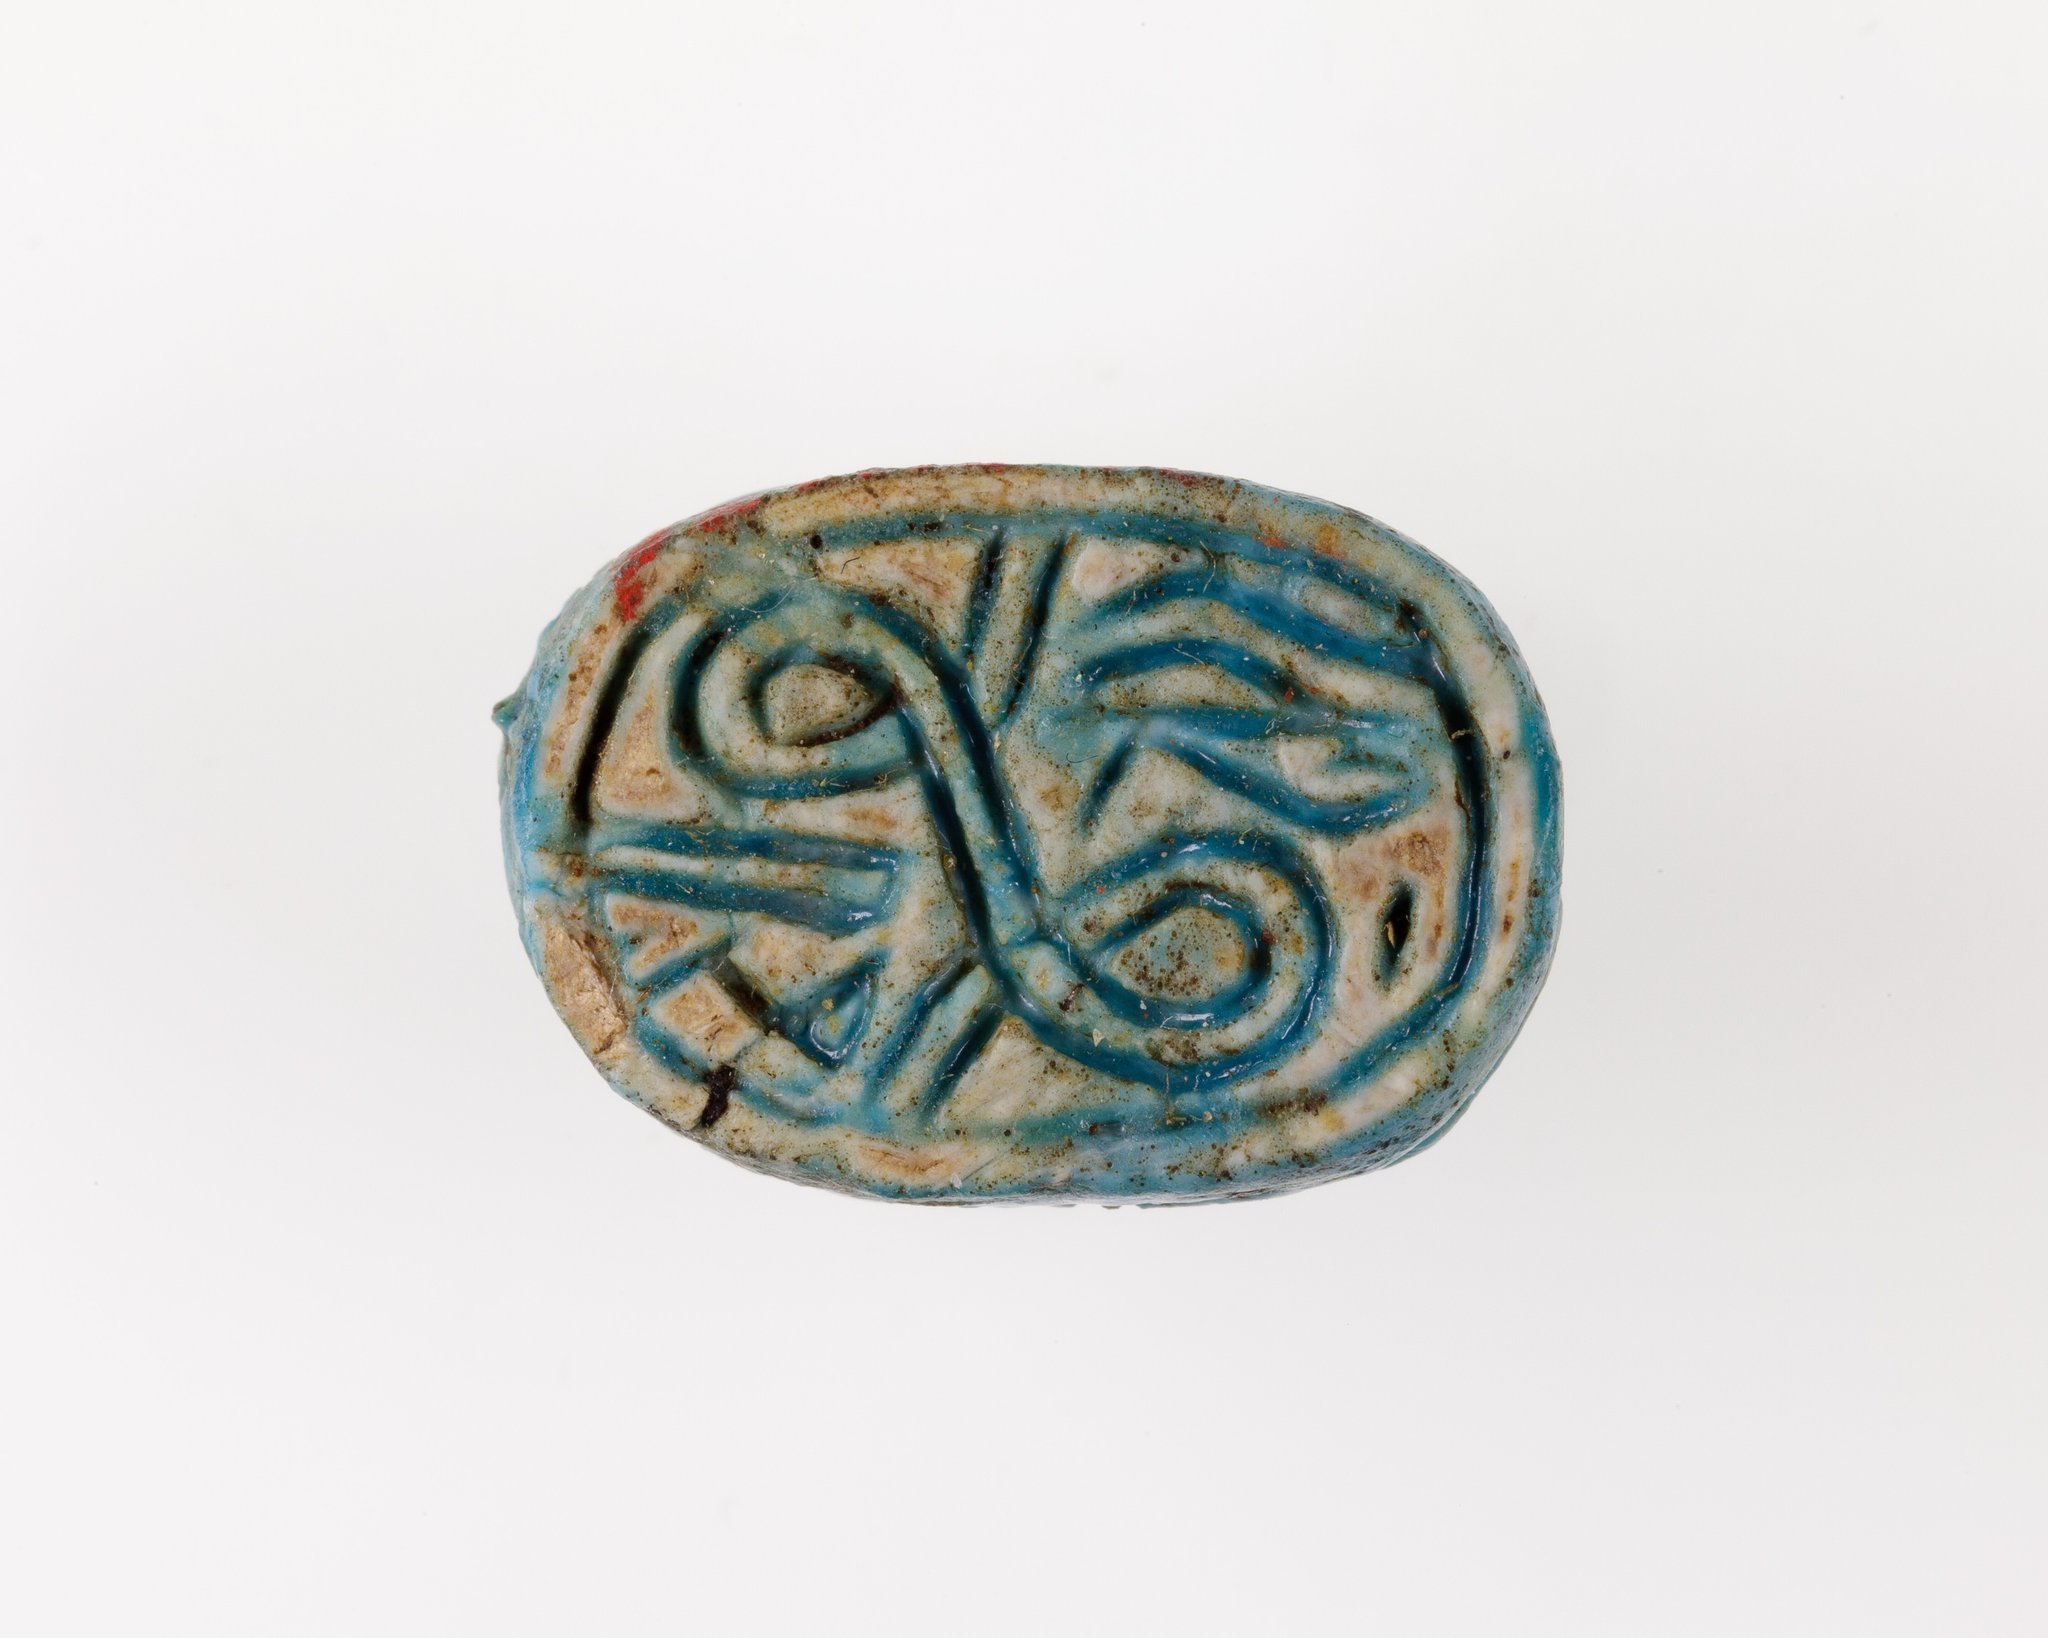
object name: scarab, scroll, red crown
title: Scarab with Scroll and Hieroglyphs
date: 1740-1640 BCE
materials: stone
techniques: glazing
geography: egypt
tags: scarabs